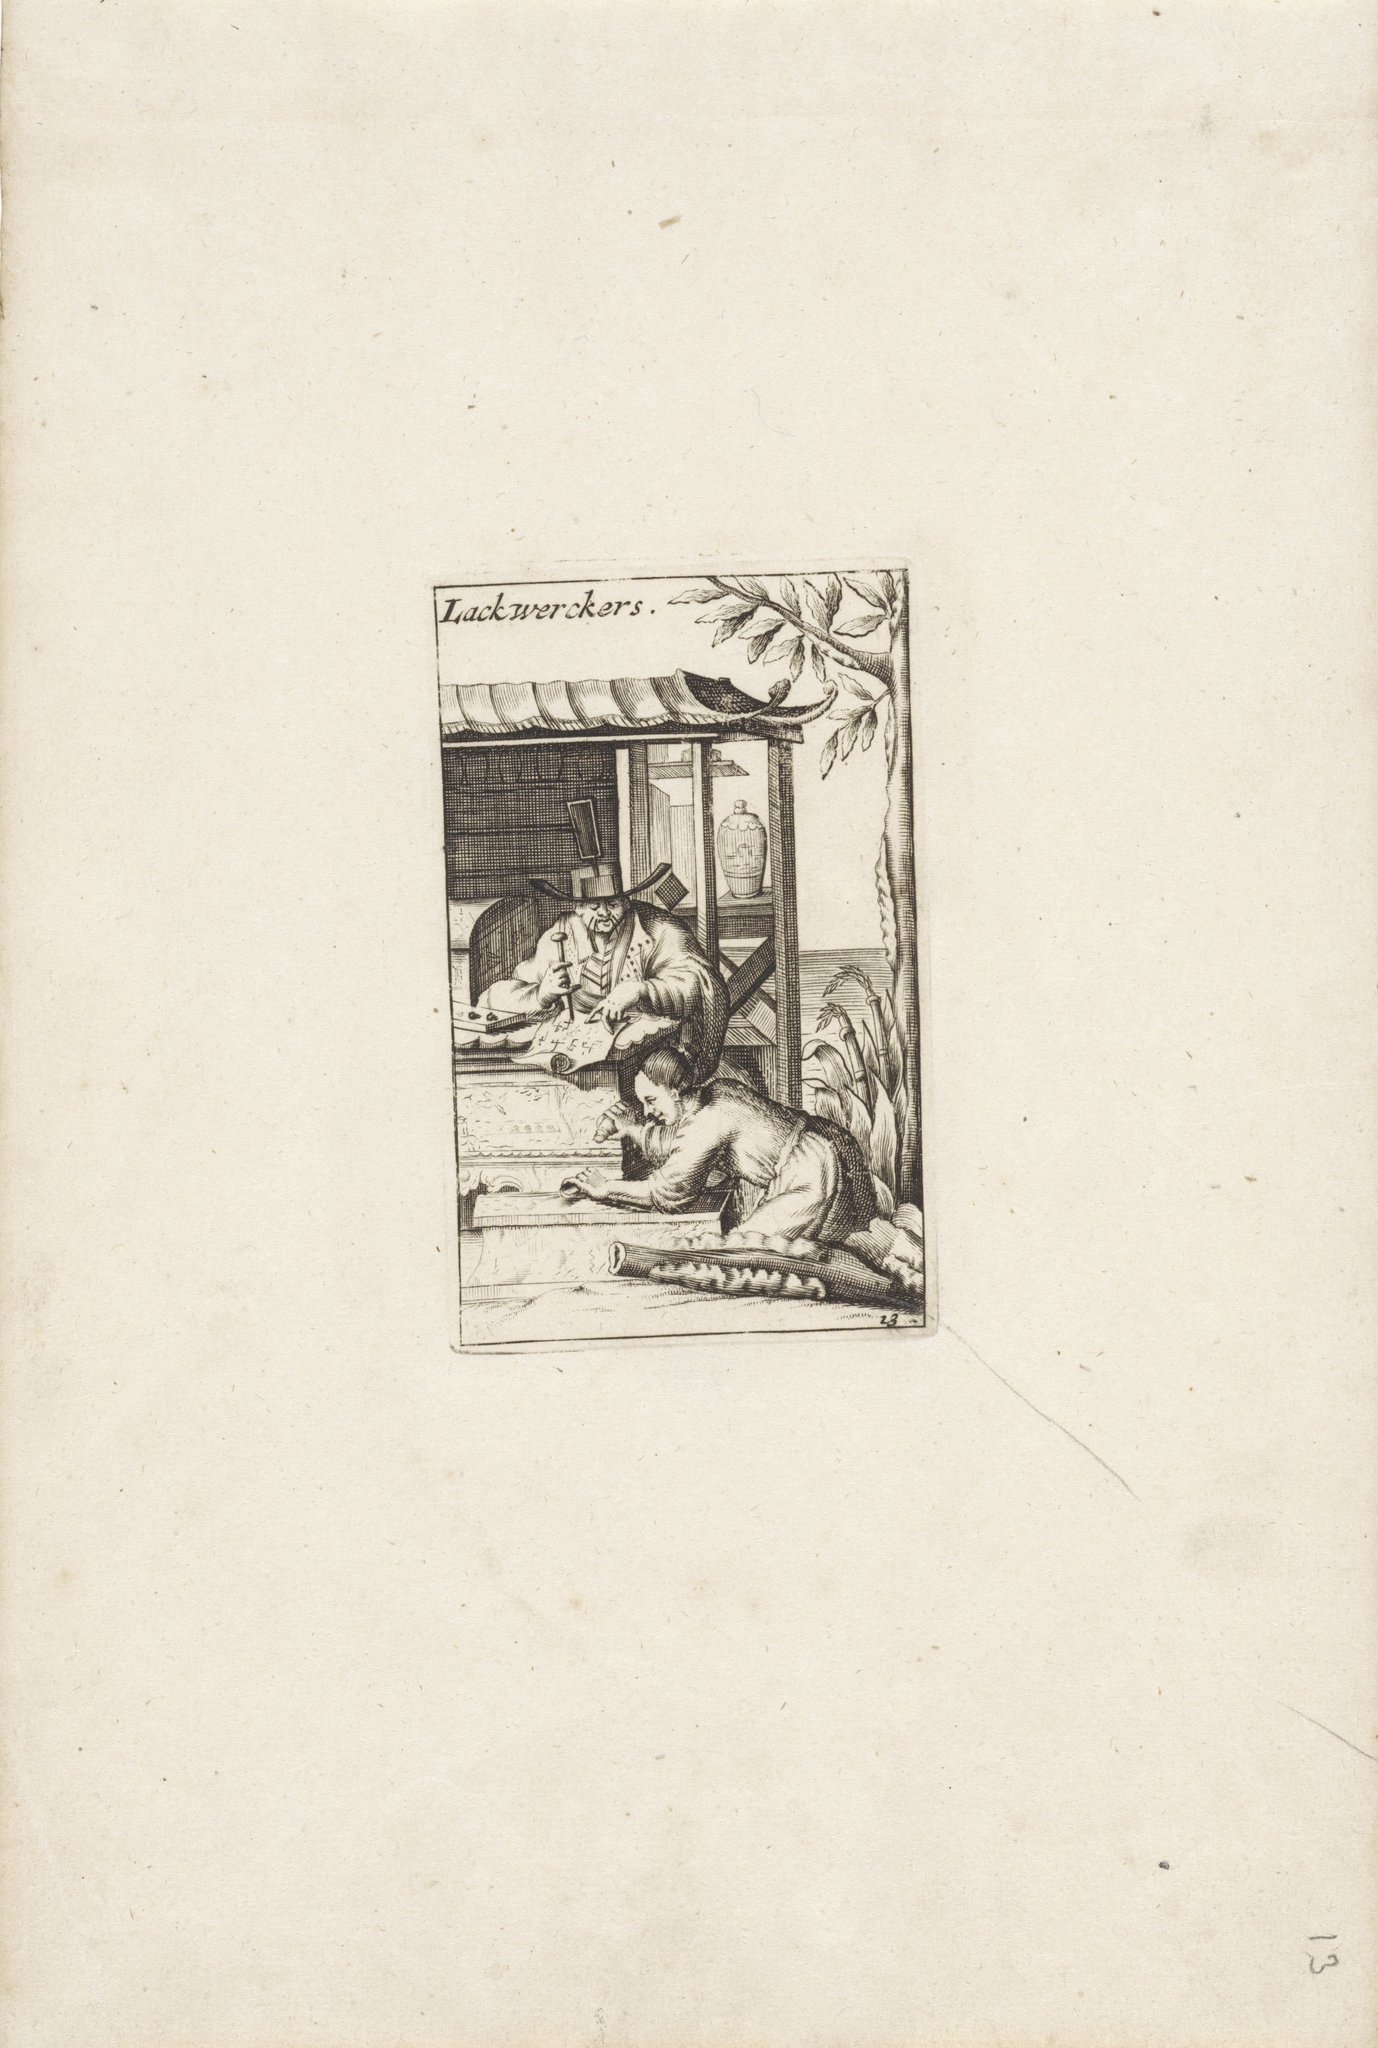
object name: print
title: Chinese lakwerkers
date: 1682-1711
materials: paper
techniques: etching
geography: amsterdam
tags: chinese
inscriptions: collector's mark: Lugt 2228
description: Deze serie bestaat uit kopieën naar de prenten in: Vries, Simon de. Curieuse aenmerckingen der bysonderste Oost en West-Indische verwonderens-waerdige dingen. Utrecht: Johannes Ribbius, 1682.